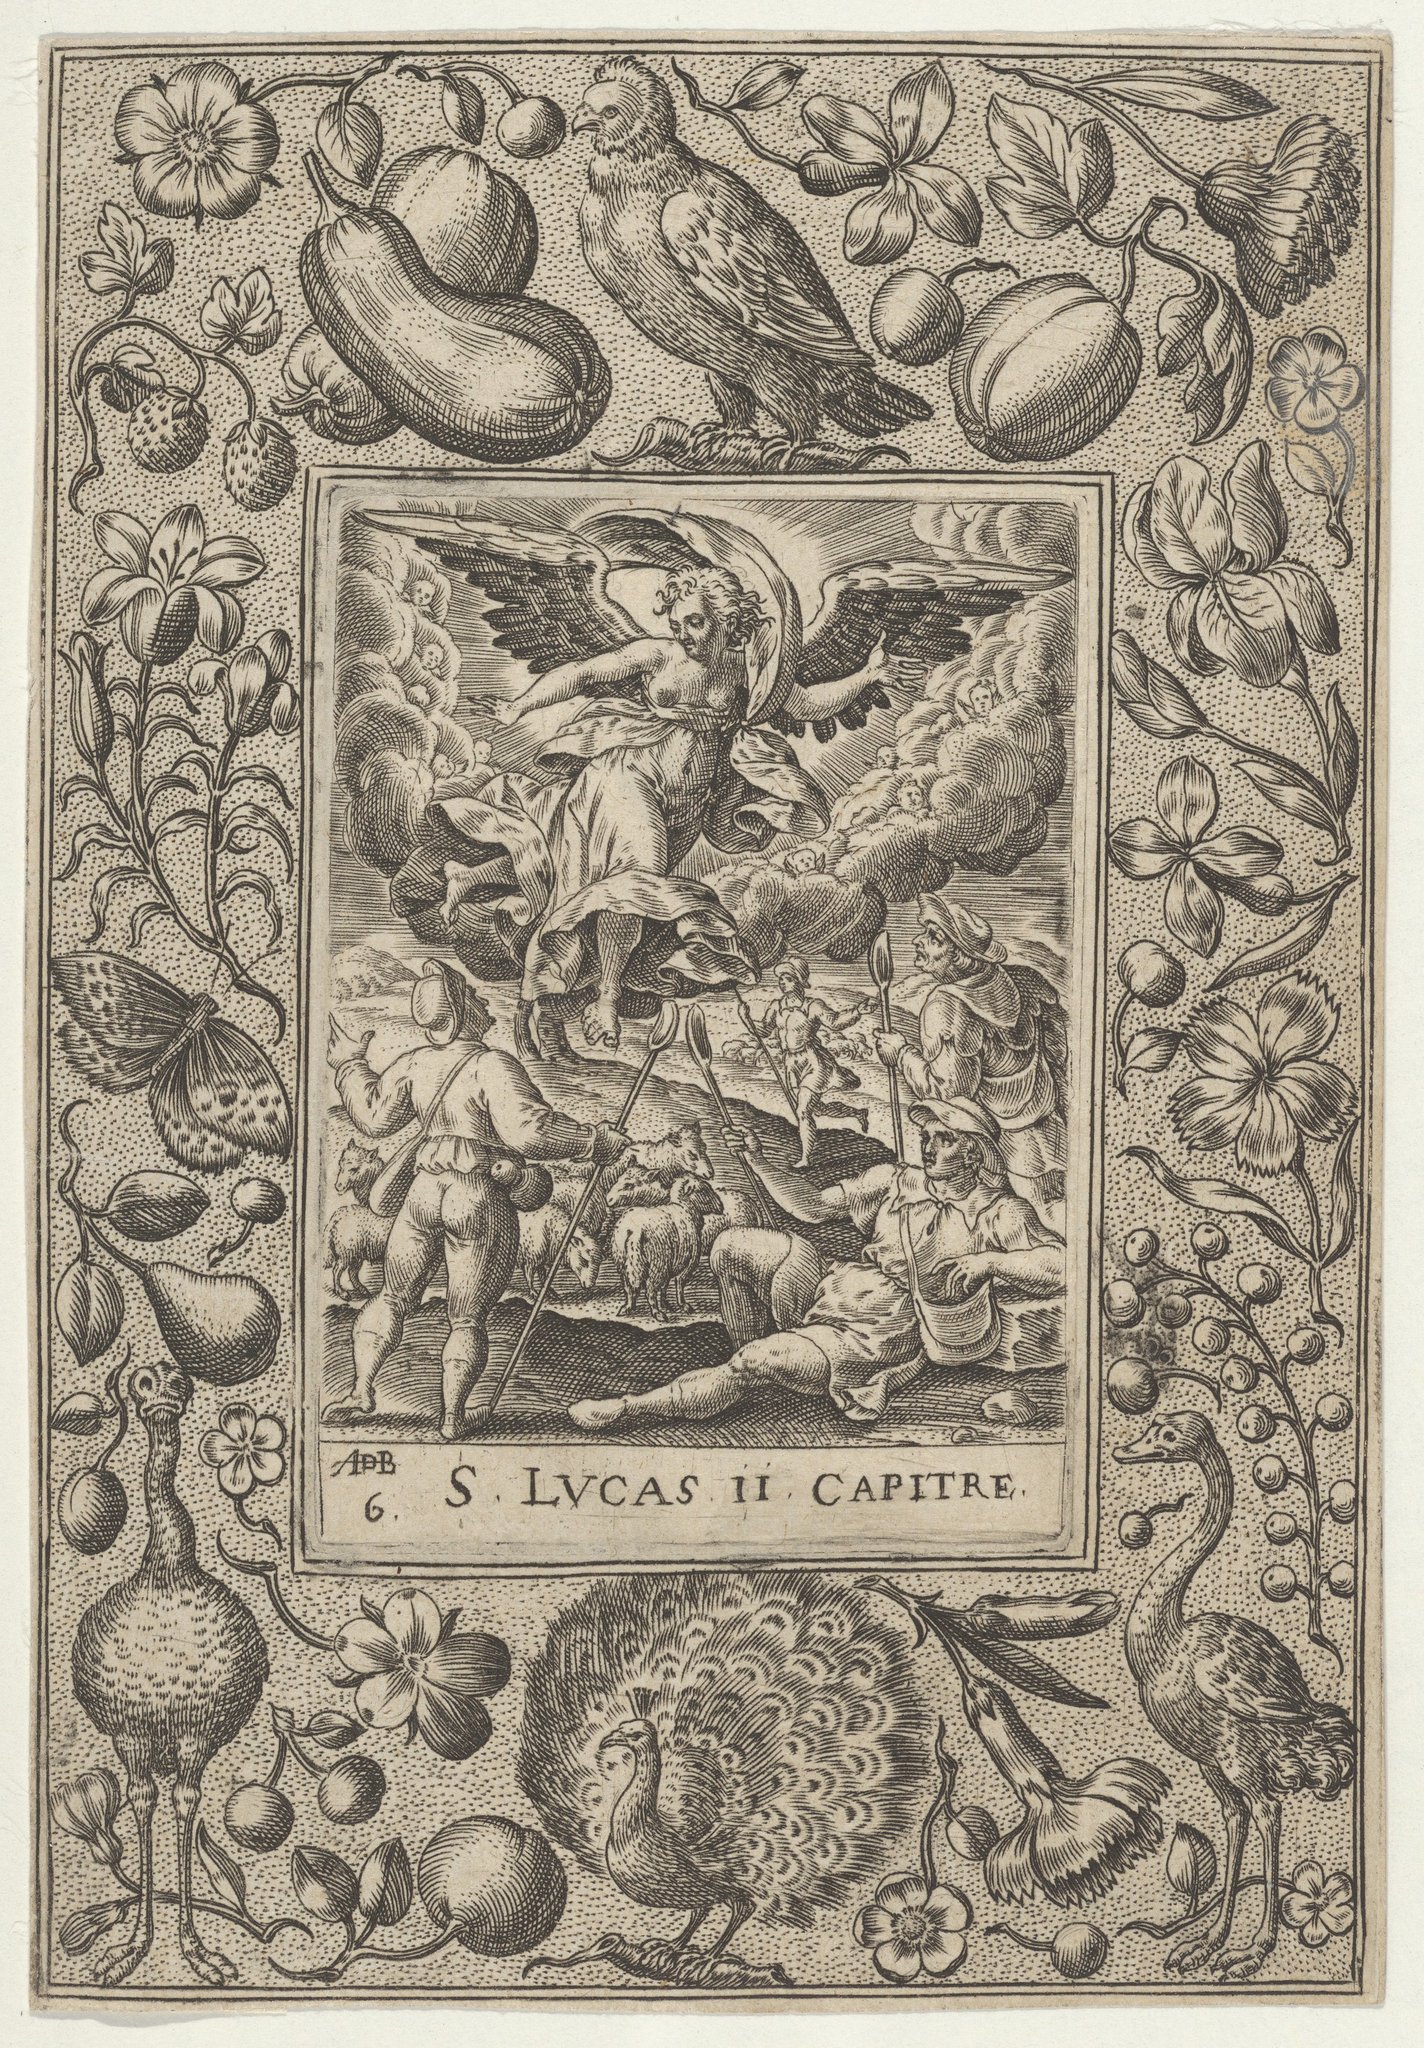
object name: print ornament architecture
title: The Annunciation to the Shepherds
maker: abraham de bruyn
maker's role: artist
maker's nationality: flemish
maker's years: 1540-1587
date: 1580-1600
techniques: engraving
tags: fruit,vegetables,peacocks,annunciation,shepherds